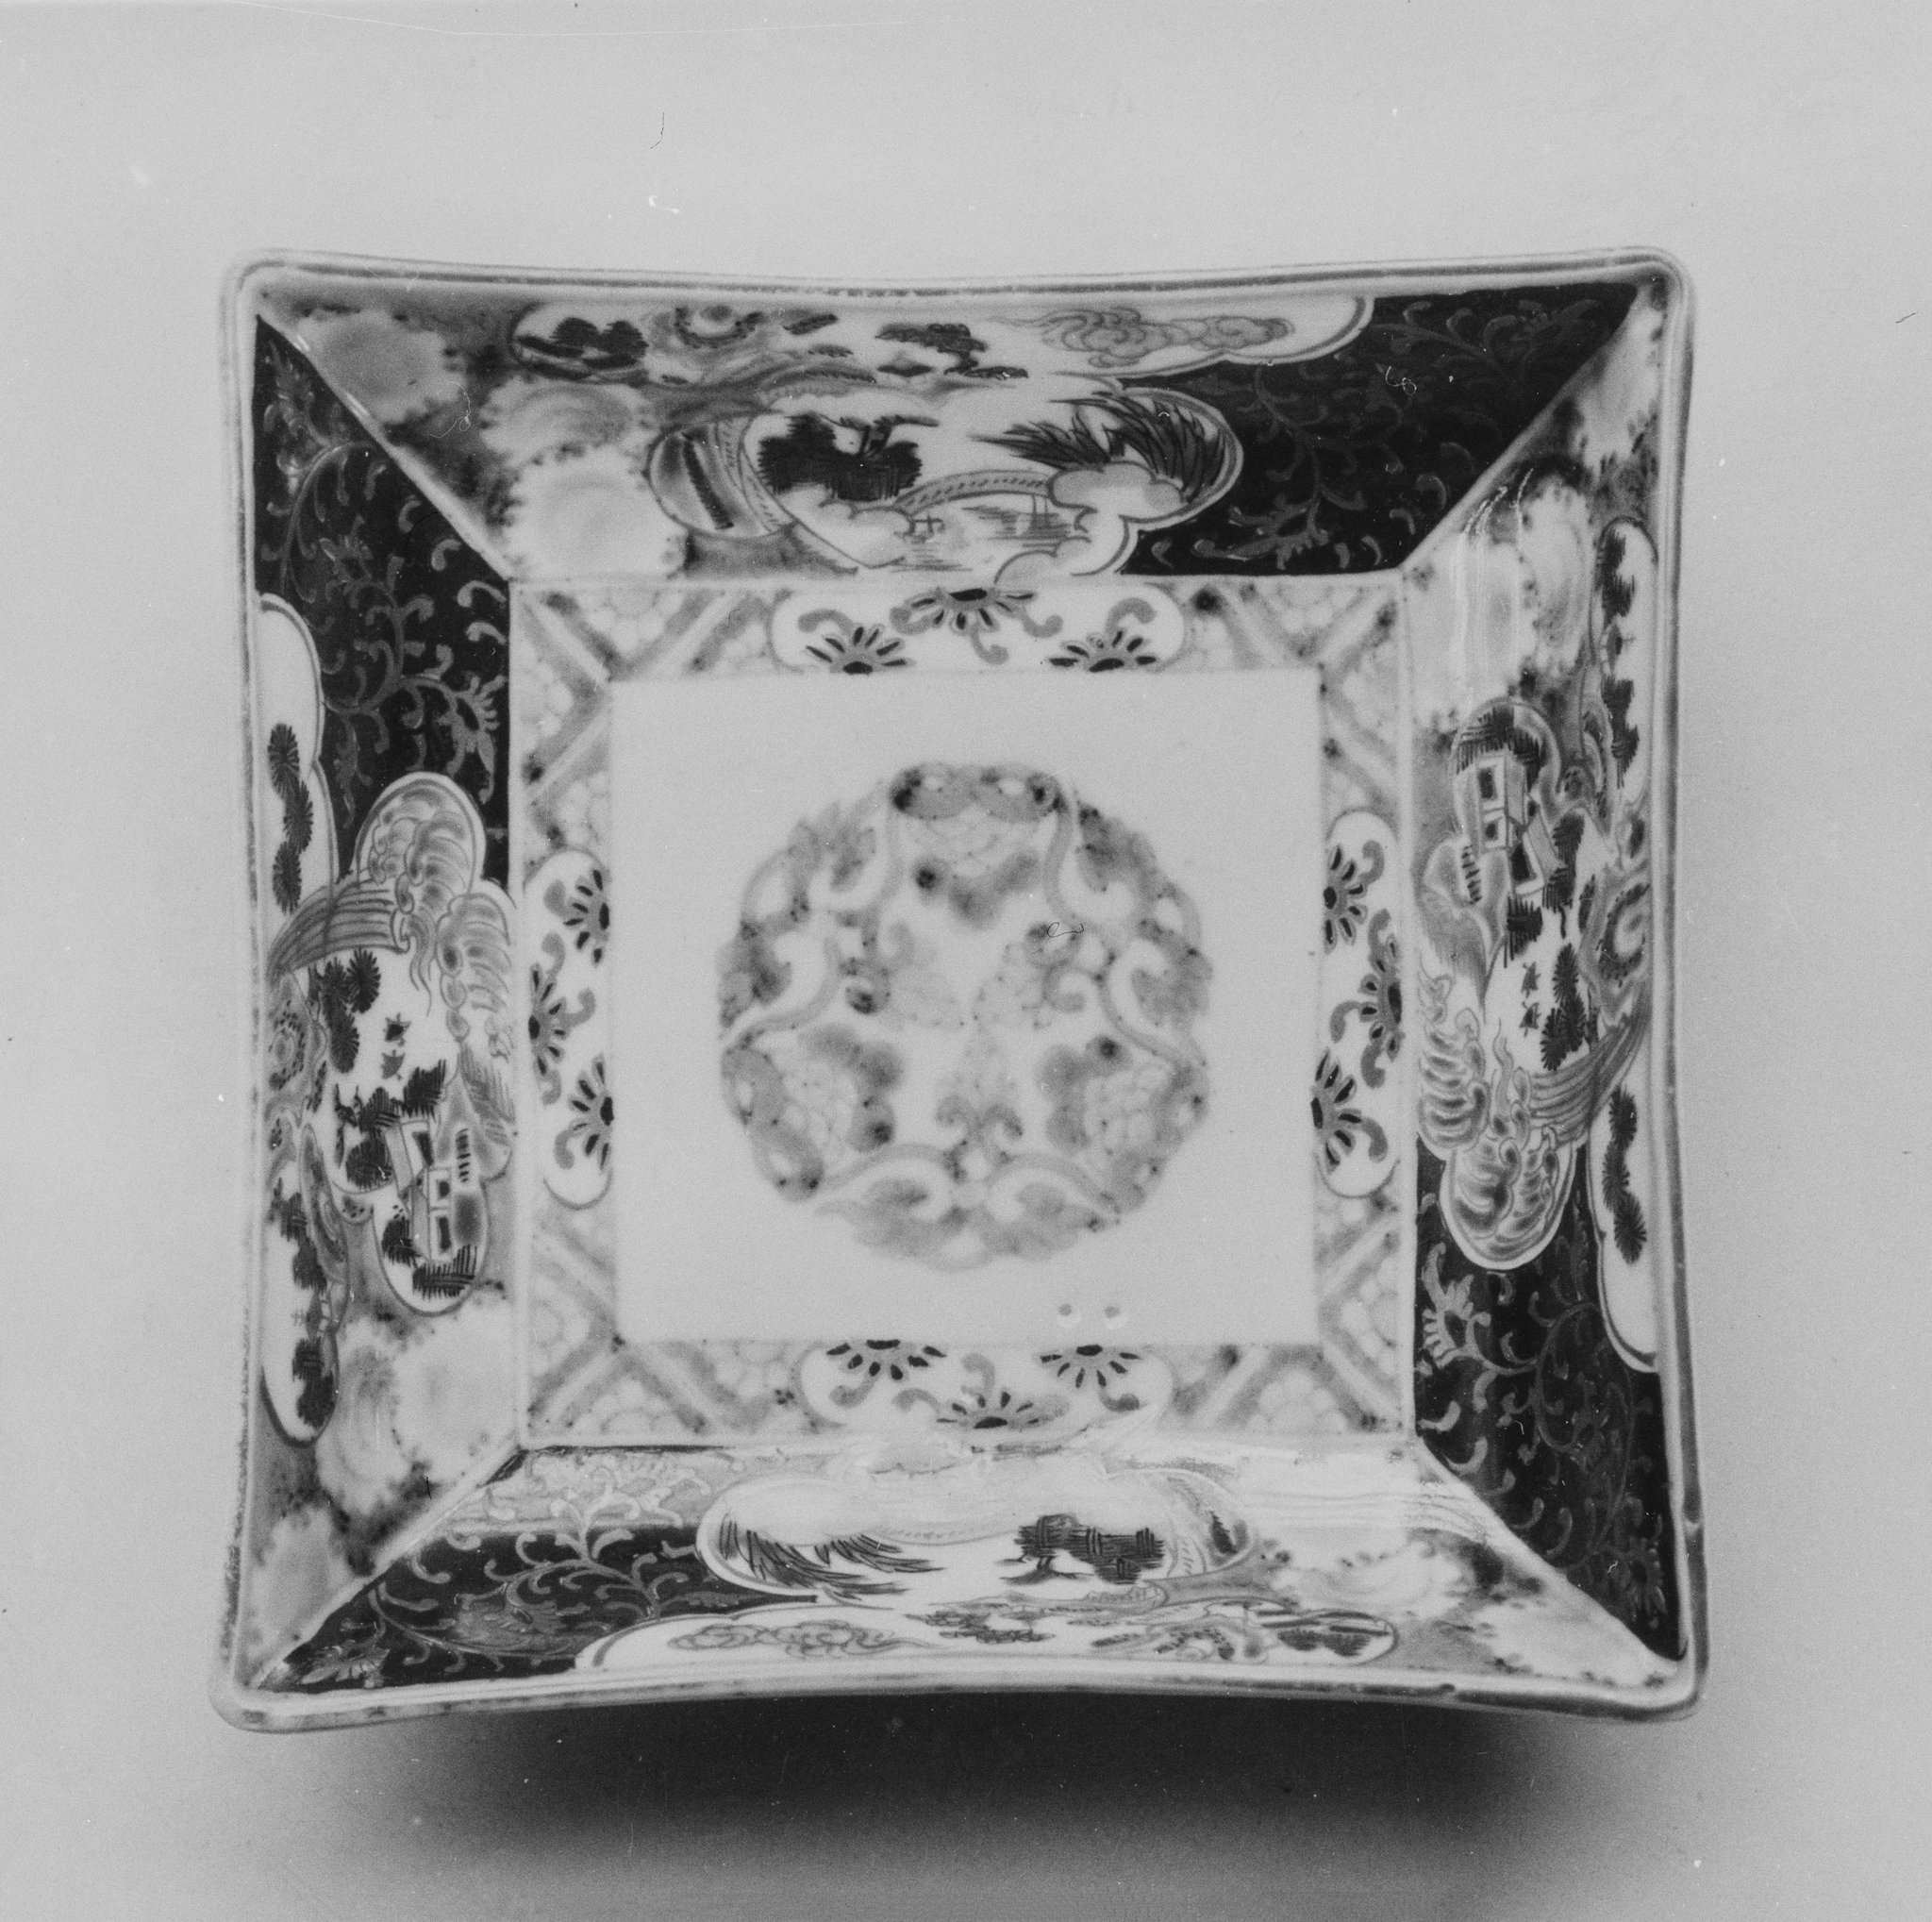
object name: dish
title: Square Dish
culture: japanese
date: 1501-1600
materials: enamel, glaze, porcelain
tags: birds